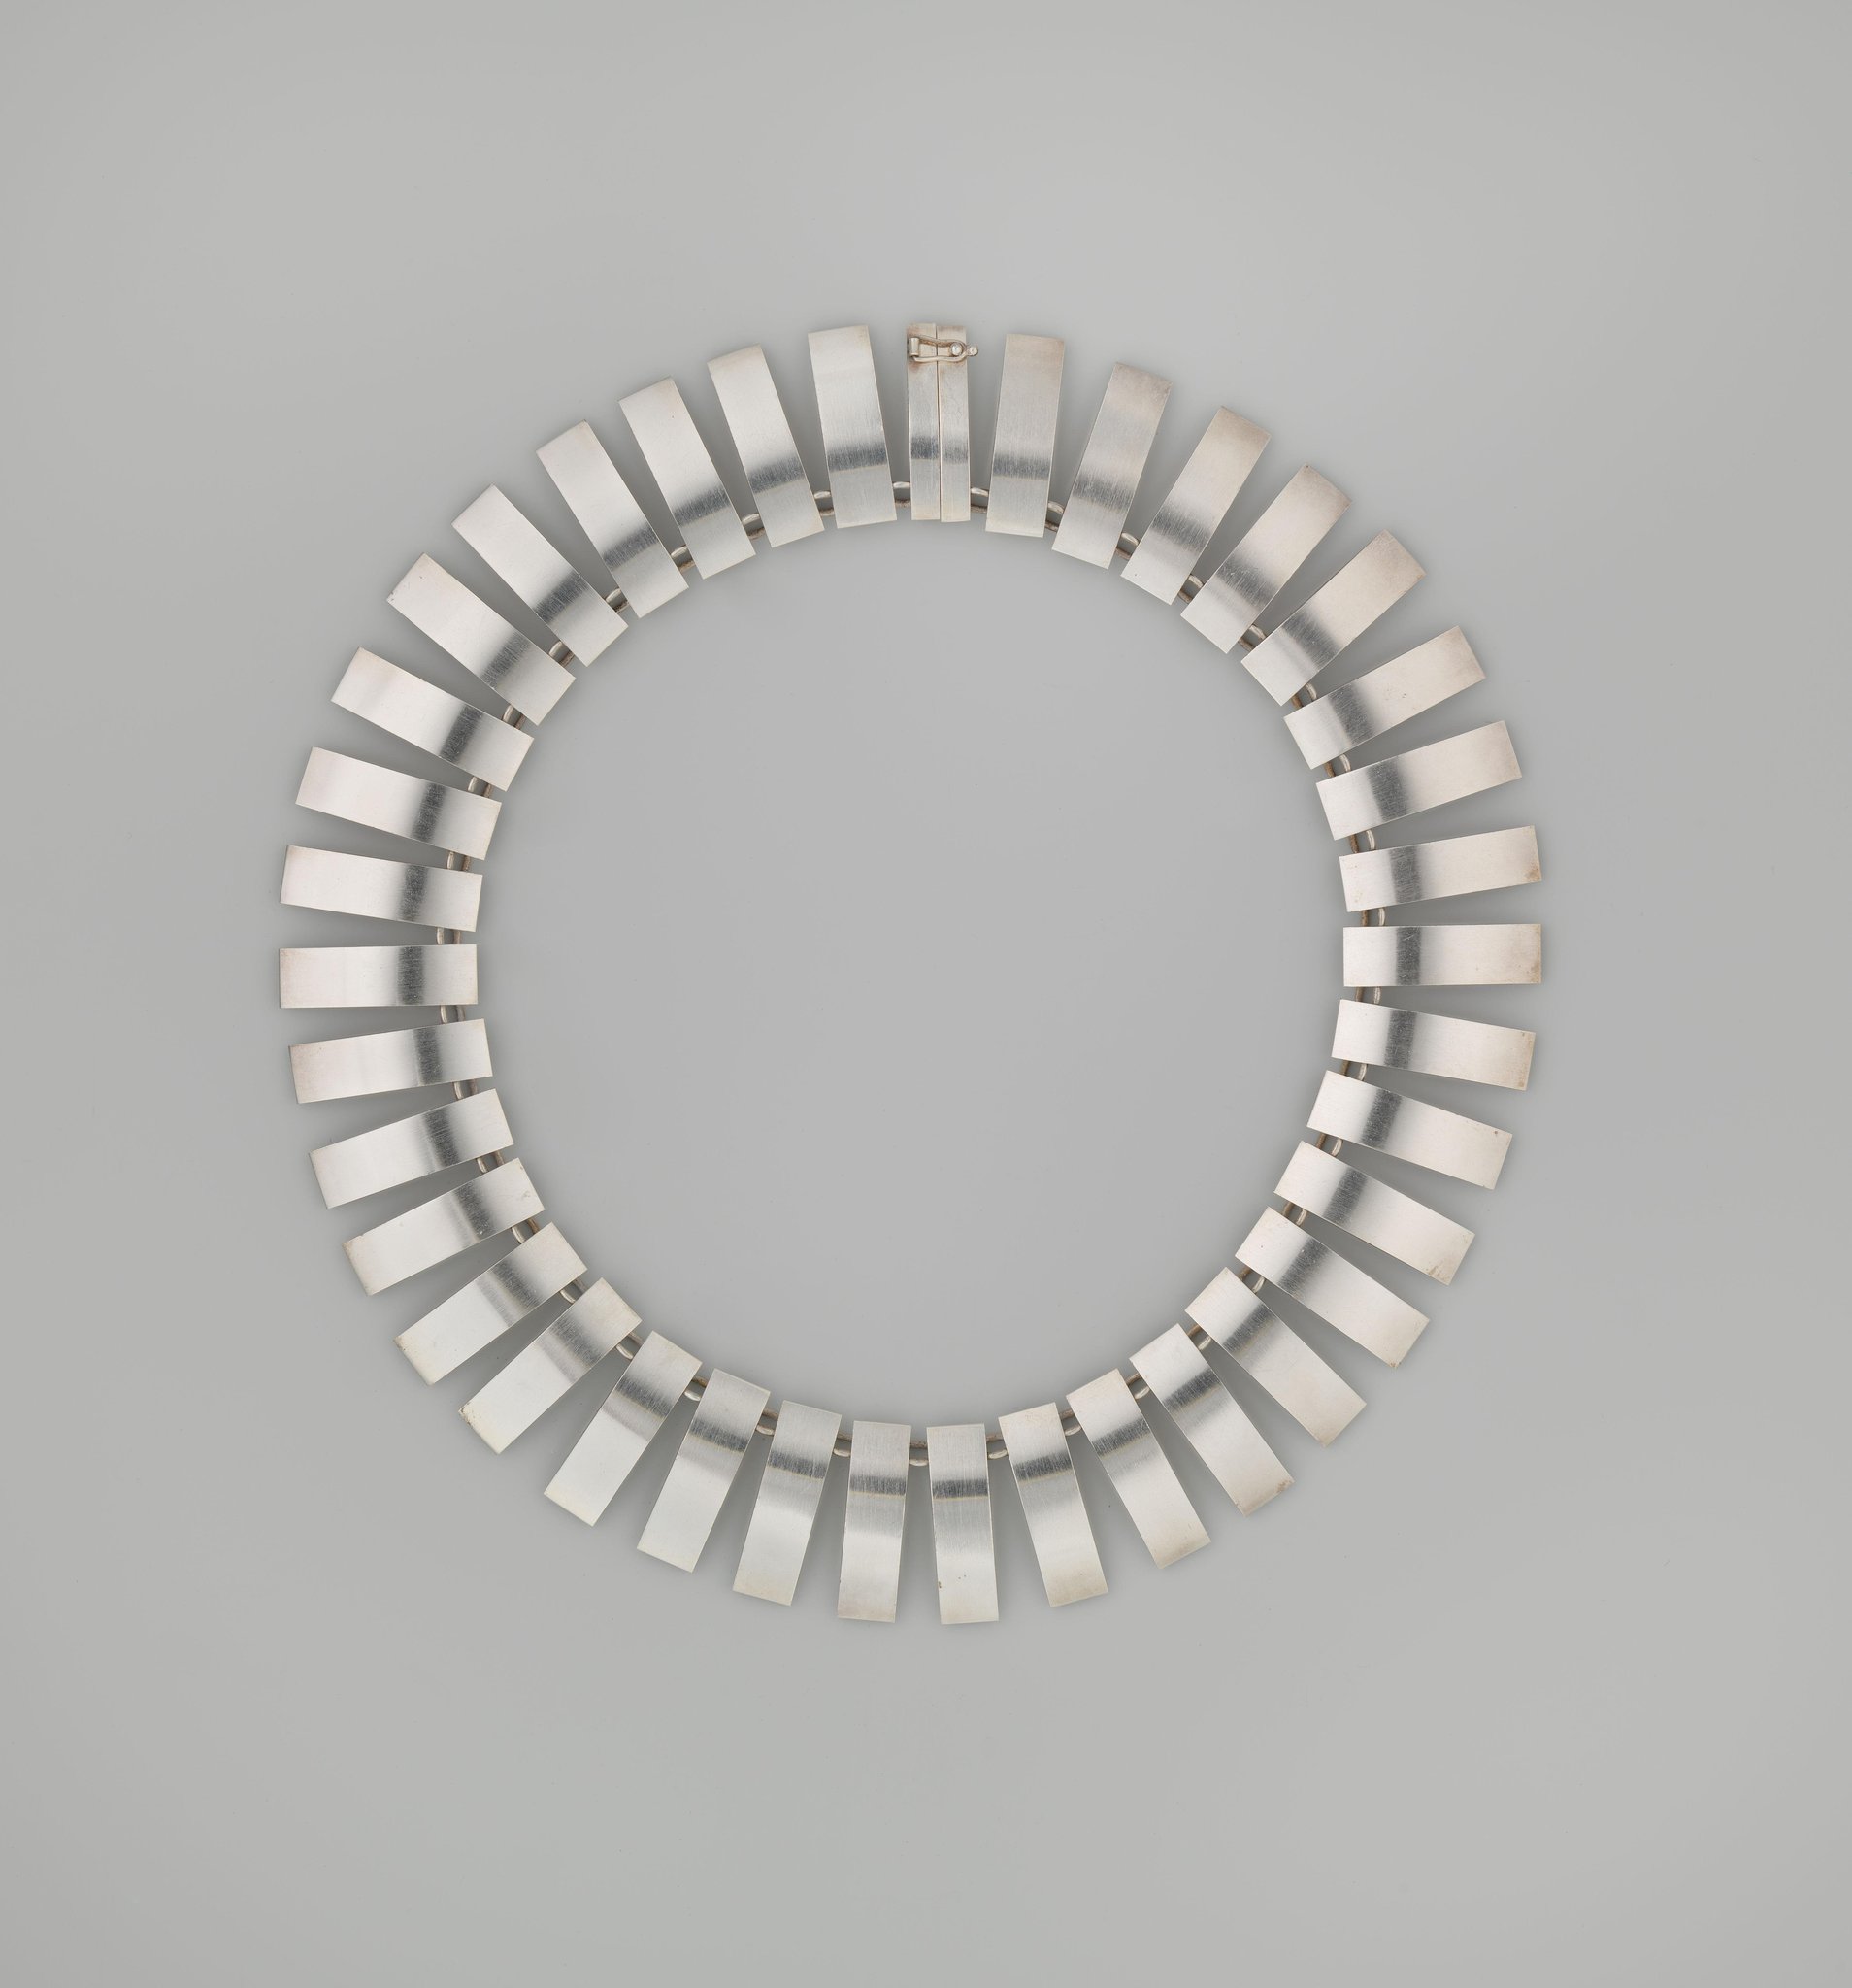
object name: necklace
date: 1960-1965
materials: silver, thread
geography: netherlands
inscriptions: alloy mark: ‘925s’, alloy mark: ‘Z1’, : ‘3’, serial number: ‘136’, : ‘20’, import mark: ‘NEK+B in een zeshoek’, : ‘20’, name: ‘Georg Jensen / Denmark’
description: The artist Arno Malinowski (1899-1976) designed this silver necklace for George Jensen, a famous Copenhagen silversmith company. The design dates from the early 1960s and is in keeping with the fashionable jewellery of the time: sleek and smooth.